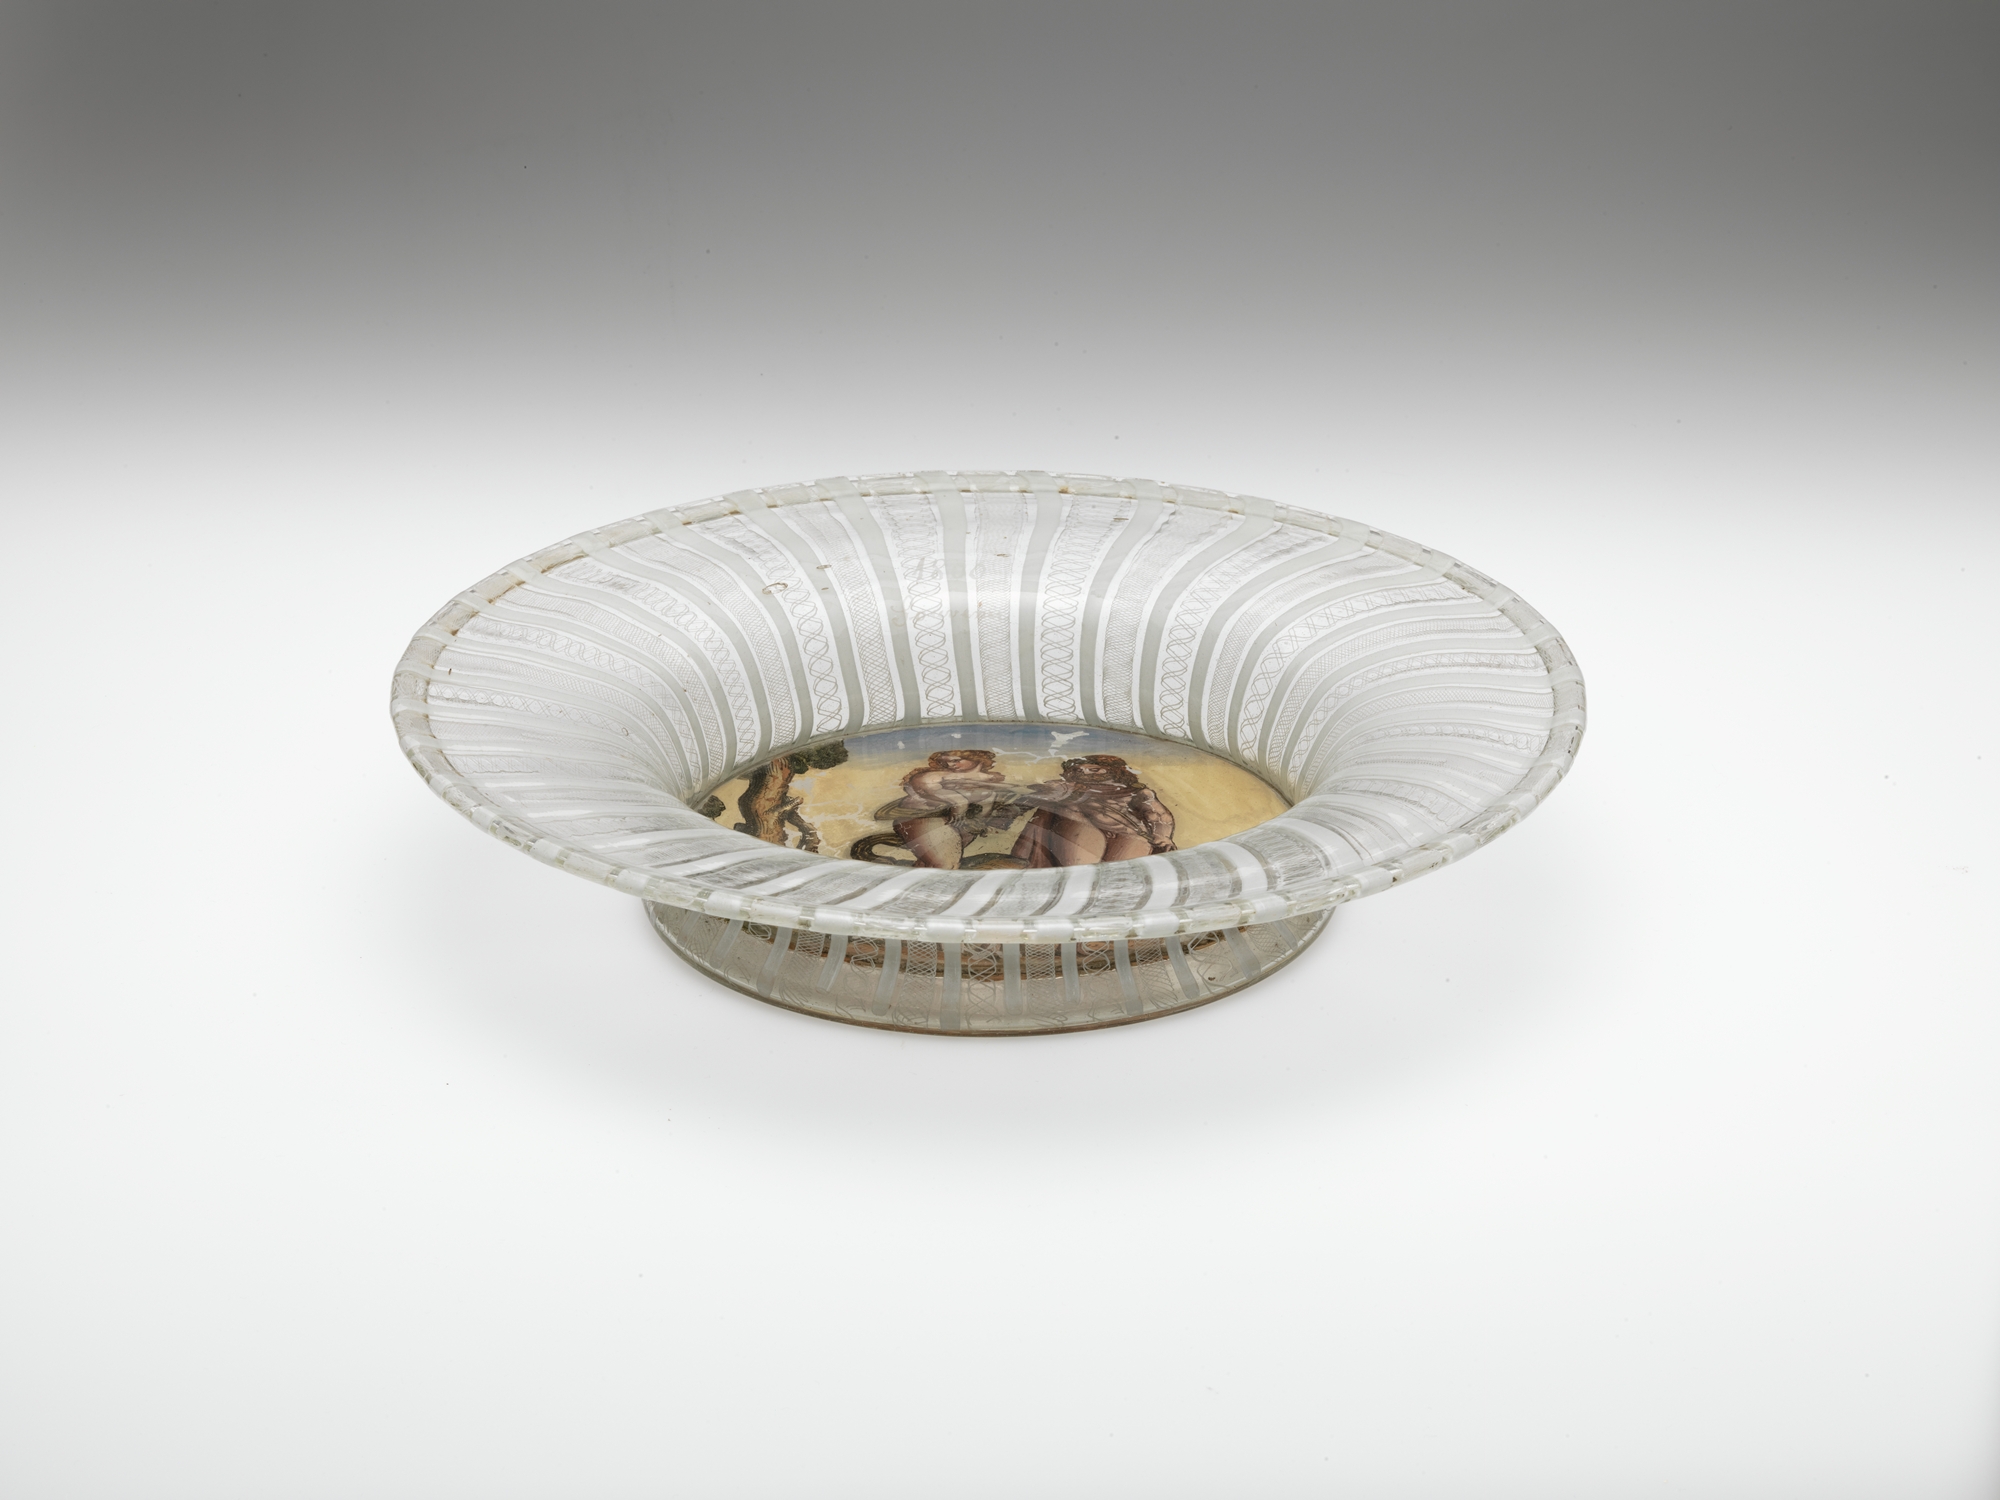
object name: plate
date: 1534-1566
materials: glass, gouache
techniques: painting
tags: musical instruments,male nudes,female nudes,orpheus,eurydice